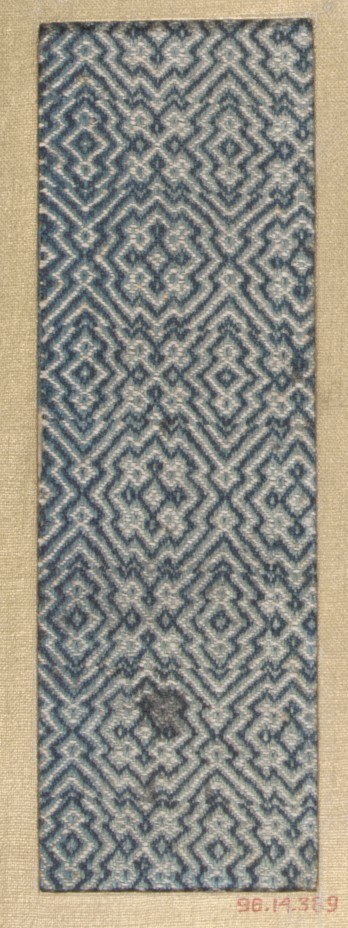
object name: piece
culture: japanese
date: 1701-1900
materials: silk